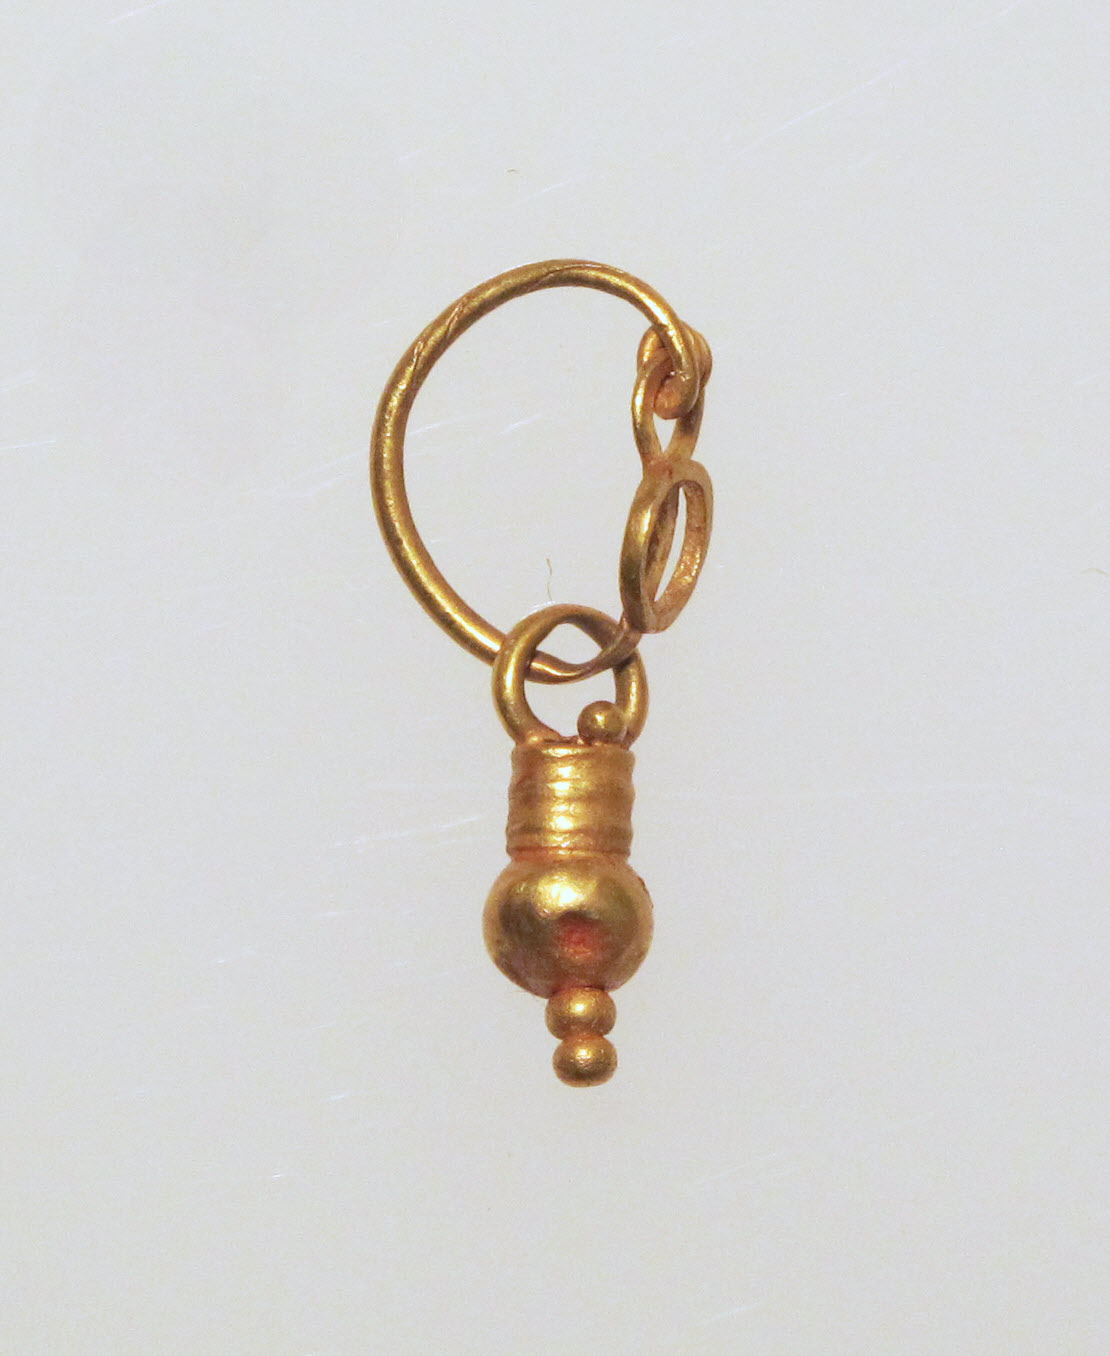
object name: earring with pendant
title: Gold earring with hollow disc and pendant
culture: roman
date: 101-200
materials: gold